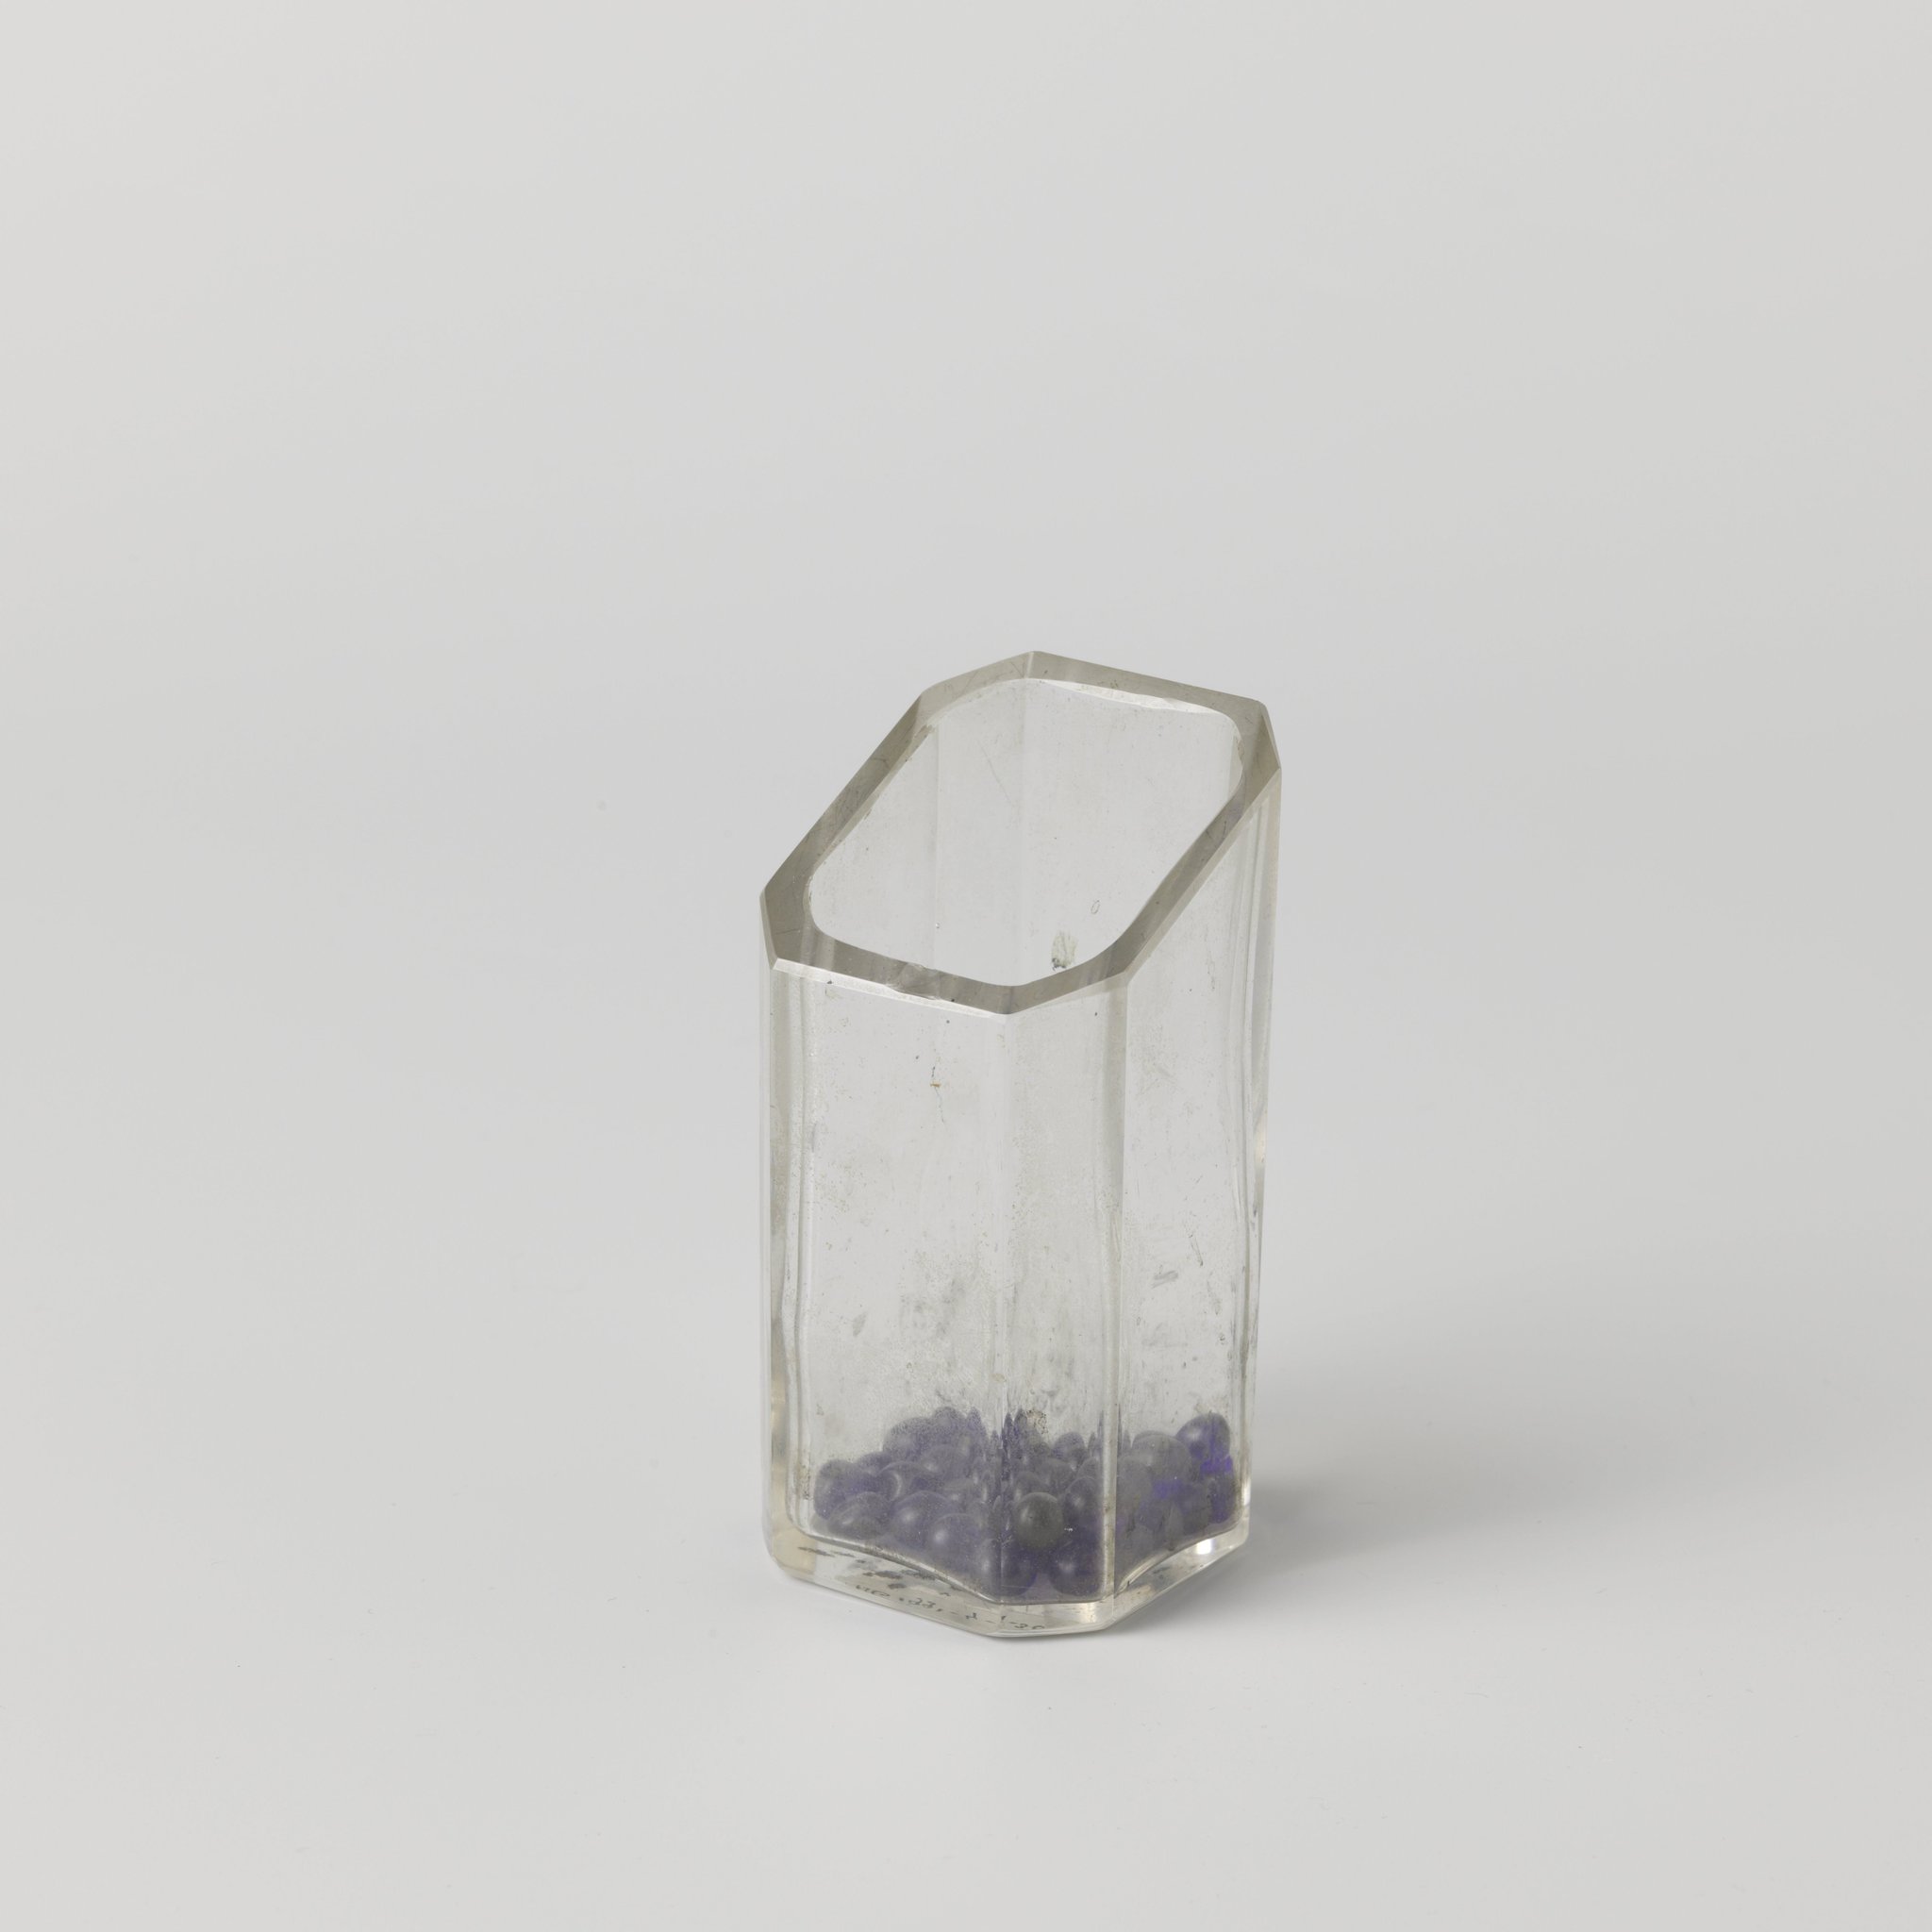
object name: pen tray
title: Bakje om kroontjespennen in weg te zetten, gebruikt door Dr. W. Drees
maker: Anonymous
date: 1910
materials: glass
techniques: casting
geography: netherlands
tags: amsterdam, the hague, willem drees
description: Glazen vierhoekig bakje met afgesneden hoeken, van boven schuin bevattende blauwe balletjes, met inkt bevlekt. Gebruikt om kroontjespennen in weg te zetten.